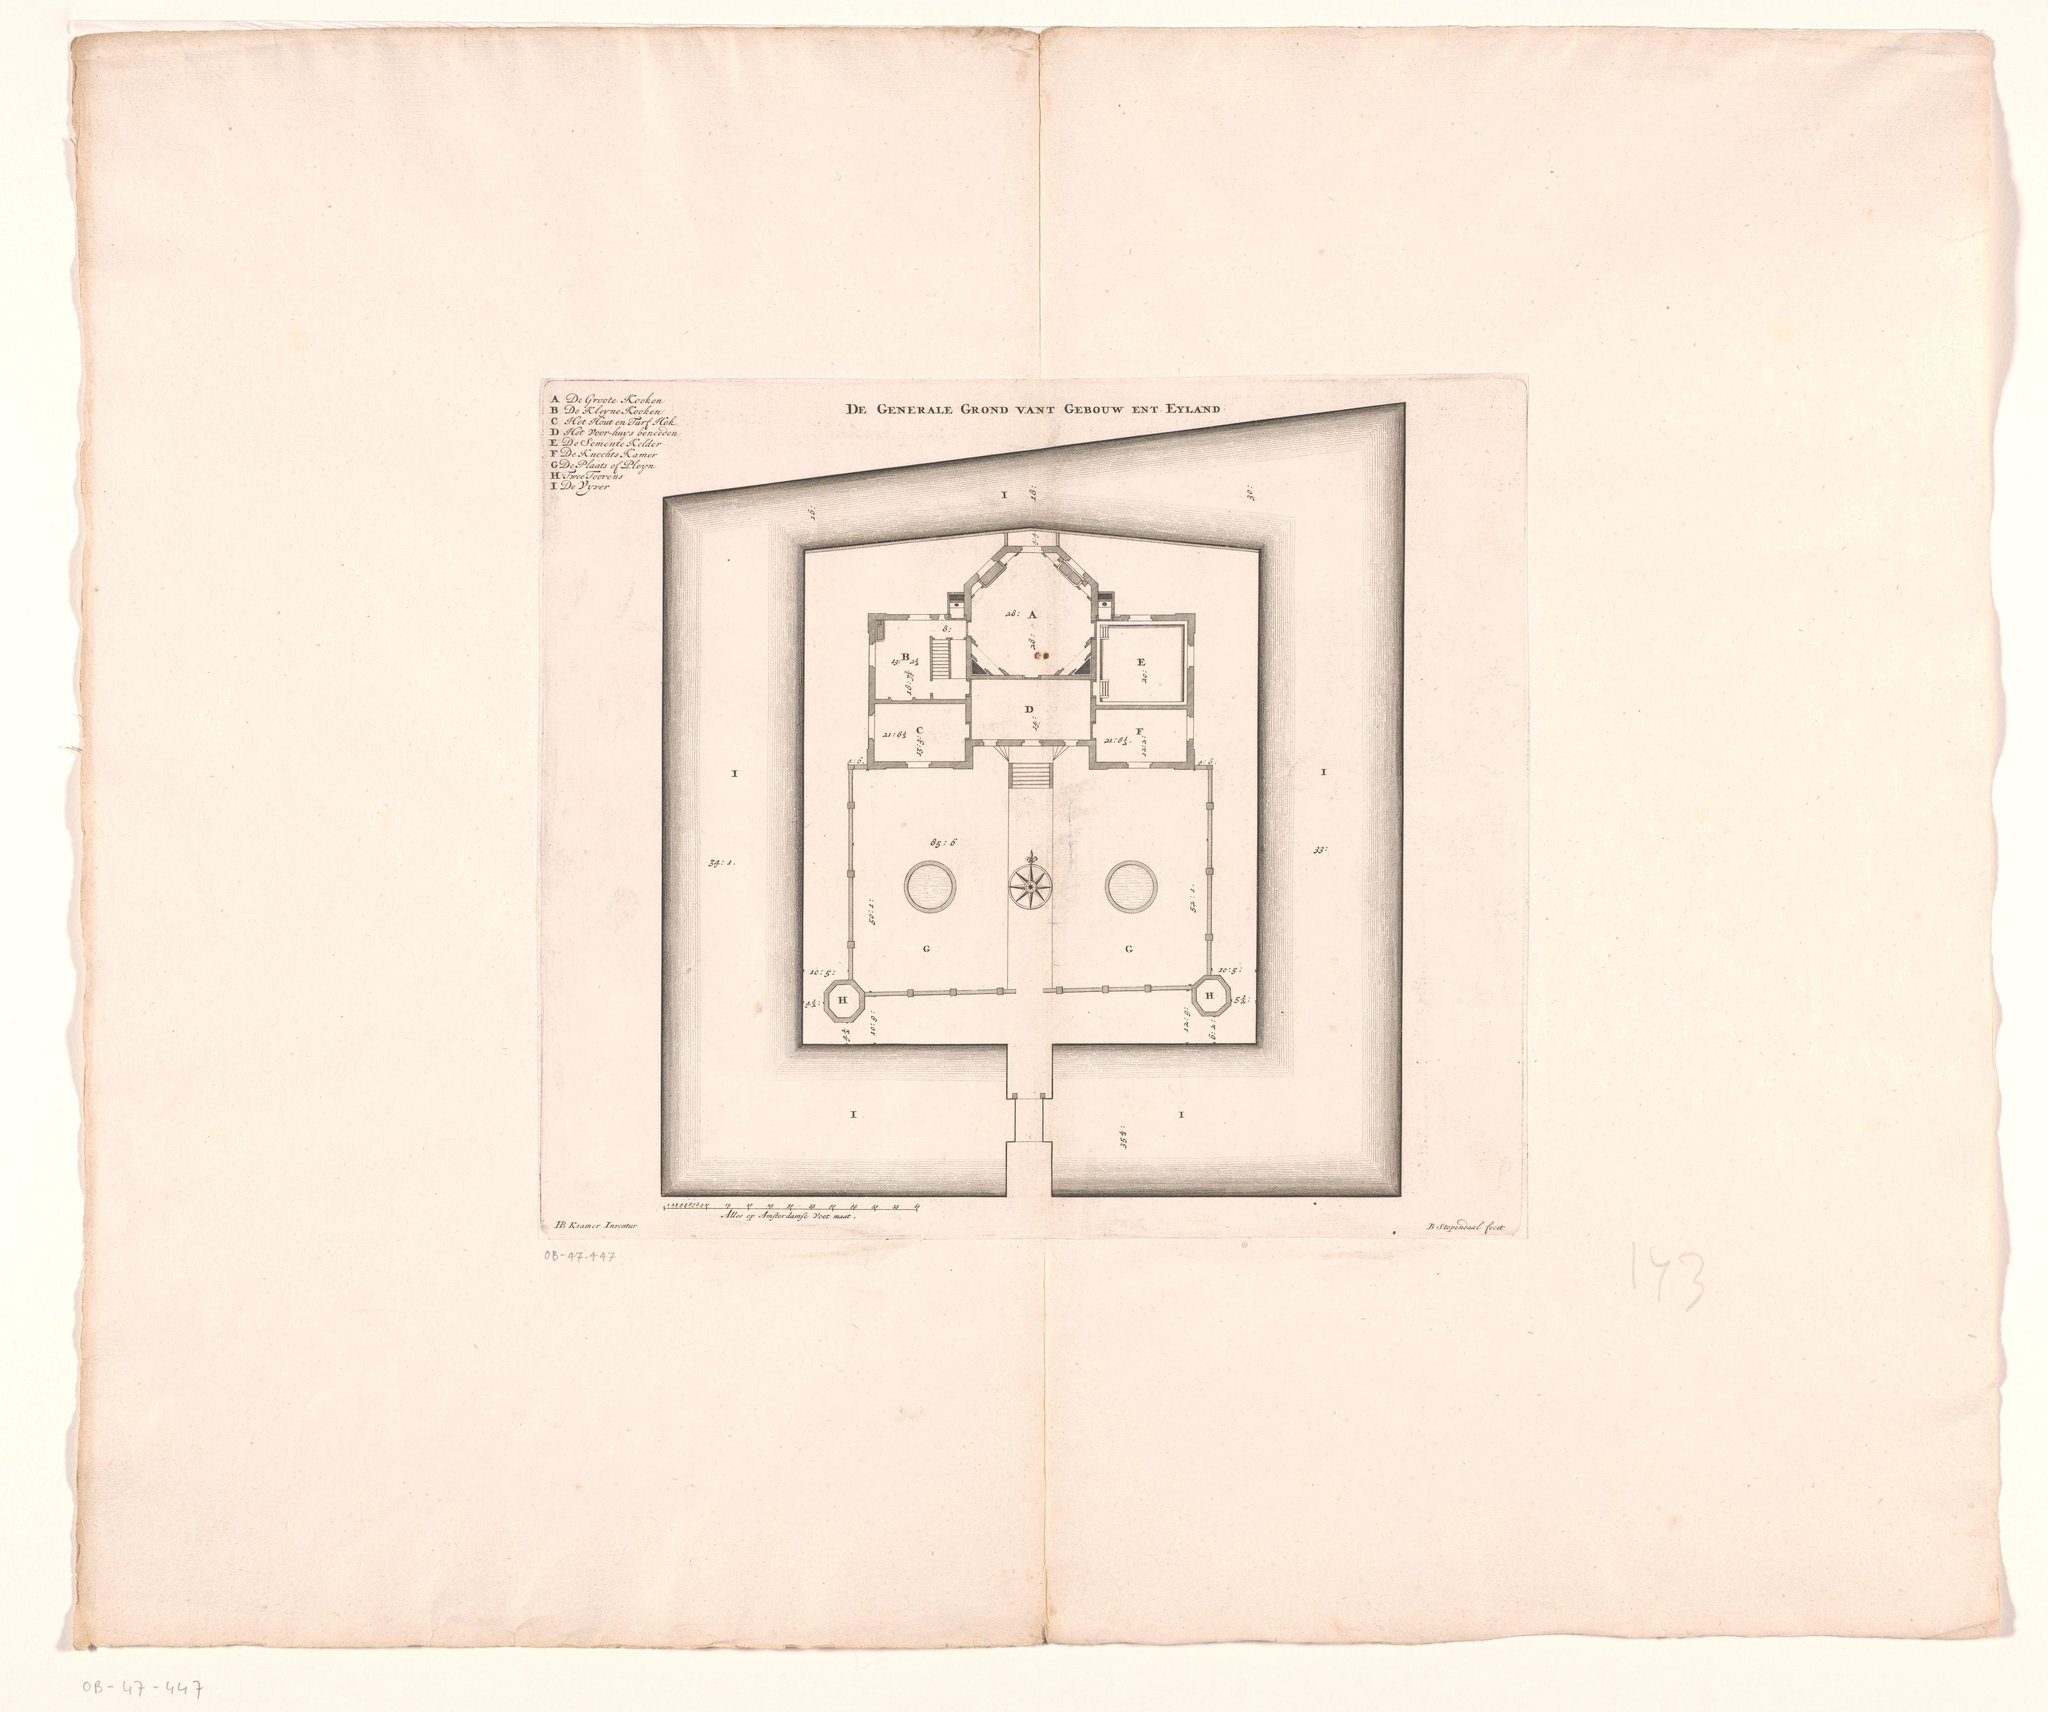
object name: ornament print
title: De Generale Grond vant Gebouw ent Eyland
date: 1687-1693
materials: paper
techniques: engraving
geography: amsterdam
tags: plan ~ architecture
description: Plattegrond van buitenplaats De Nes of Realeneiland te Vreeland. Het voor de Amsterdamse familie Reaal in 1687 gebouwde buitenhuis lag op een eiland in de Vecht.